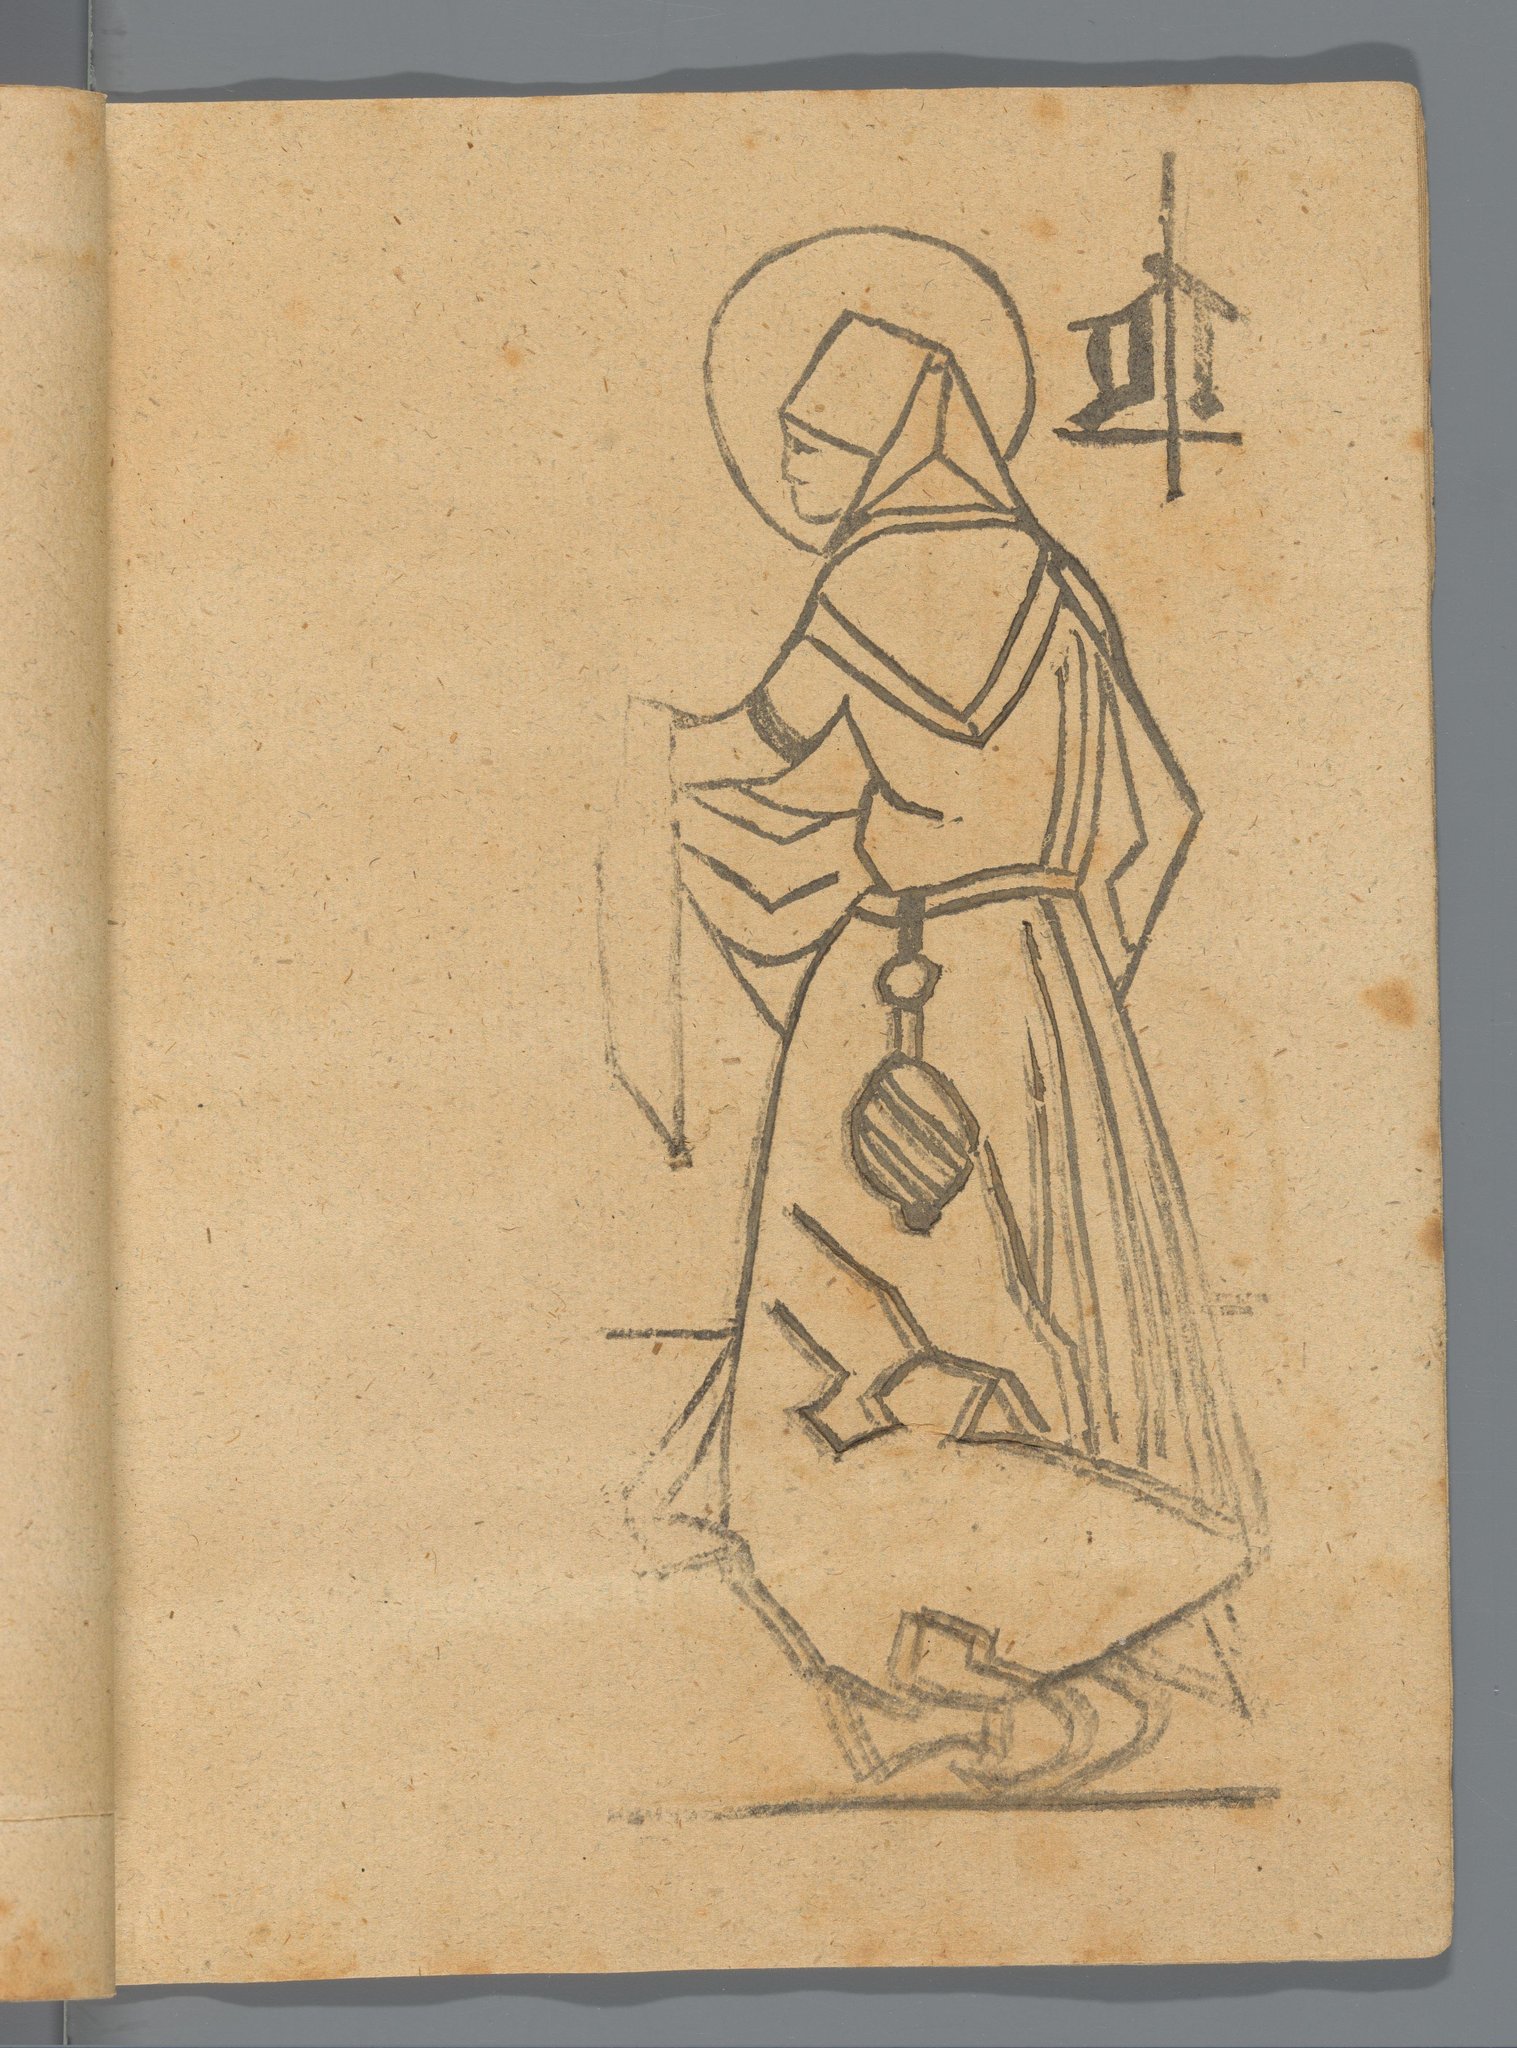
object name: album leaf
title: Heiligen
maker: Anonymous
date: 1800-1899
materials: paper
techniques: woodcut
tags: saints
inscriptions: collector's mark: Lugt 2166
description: Deze prent maakt deel uit van een album.